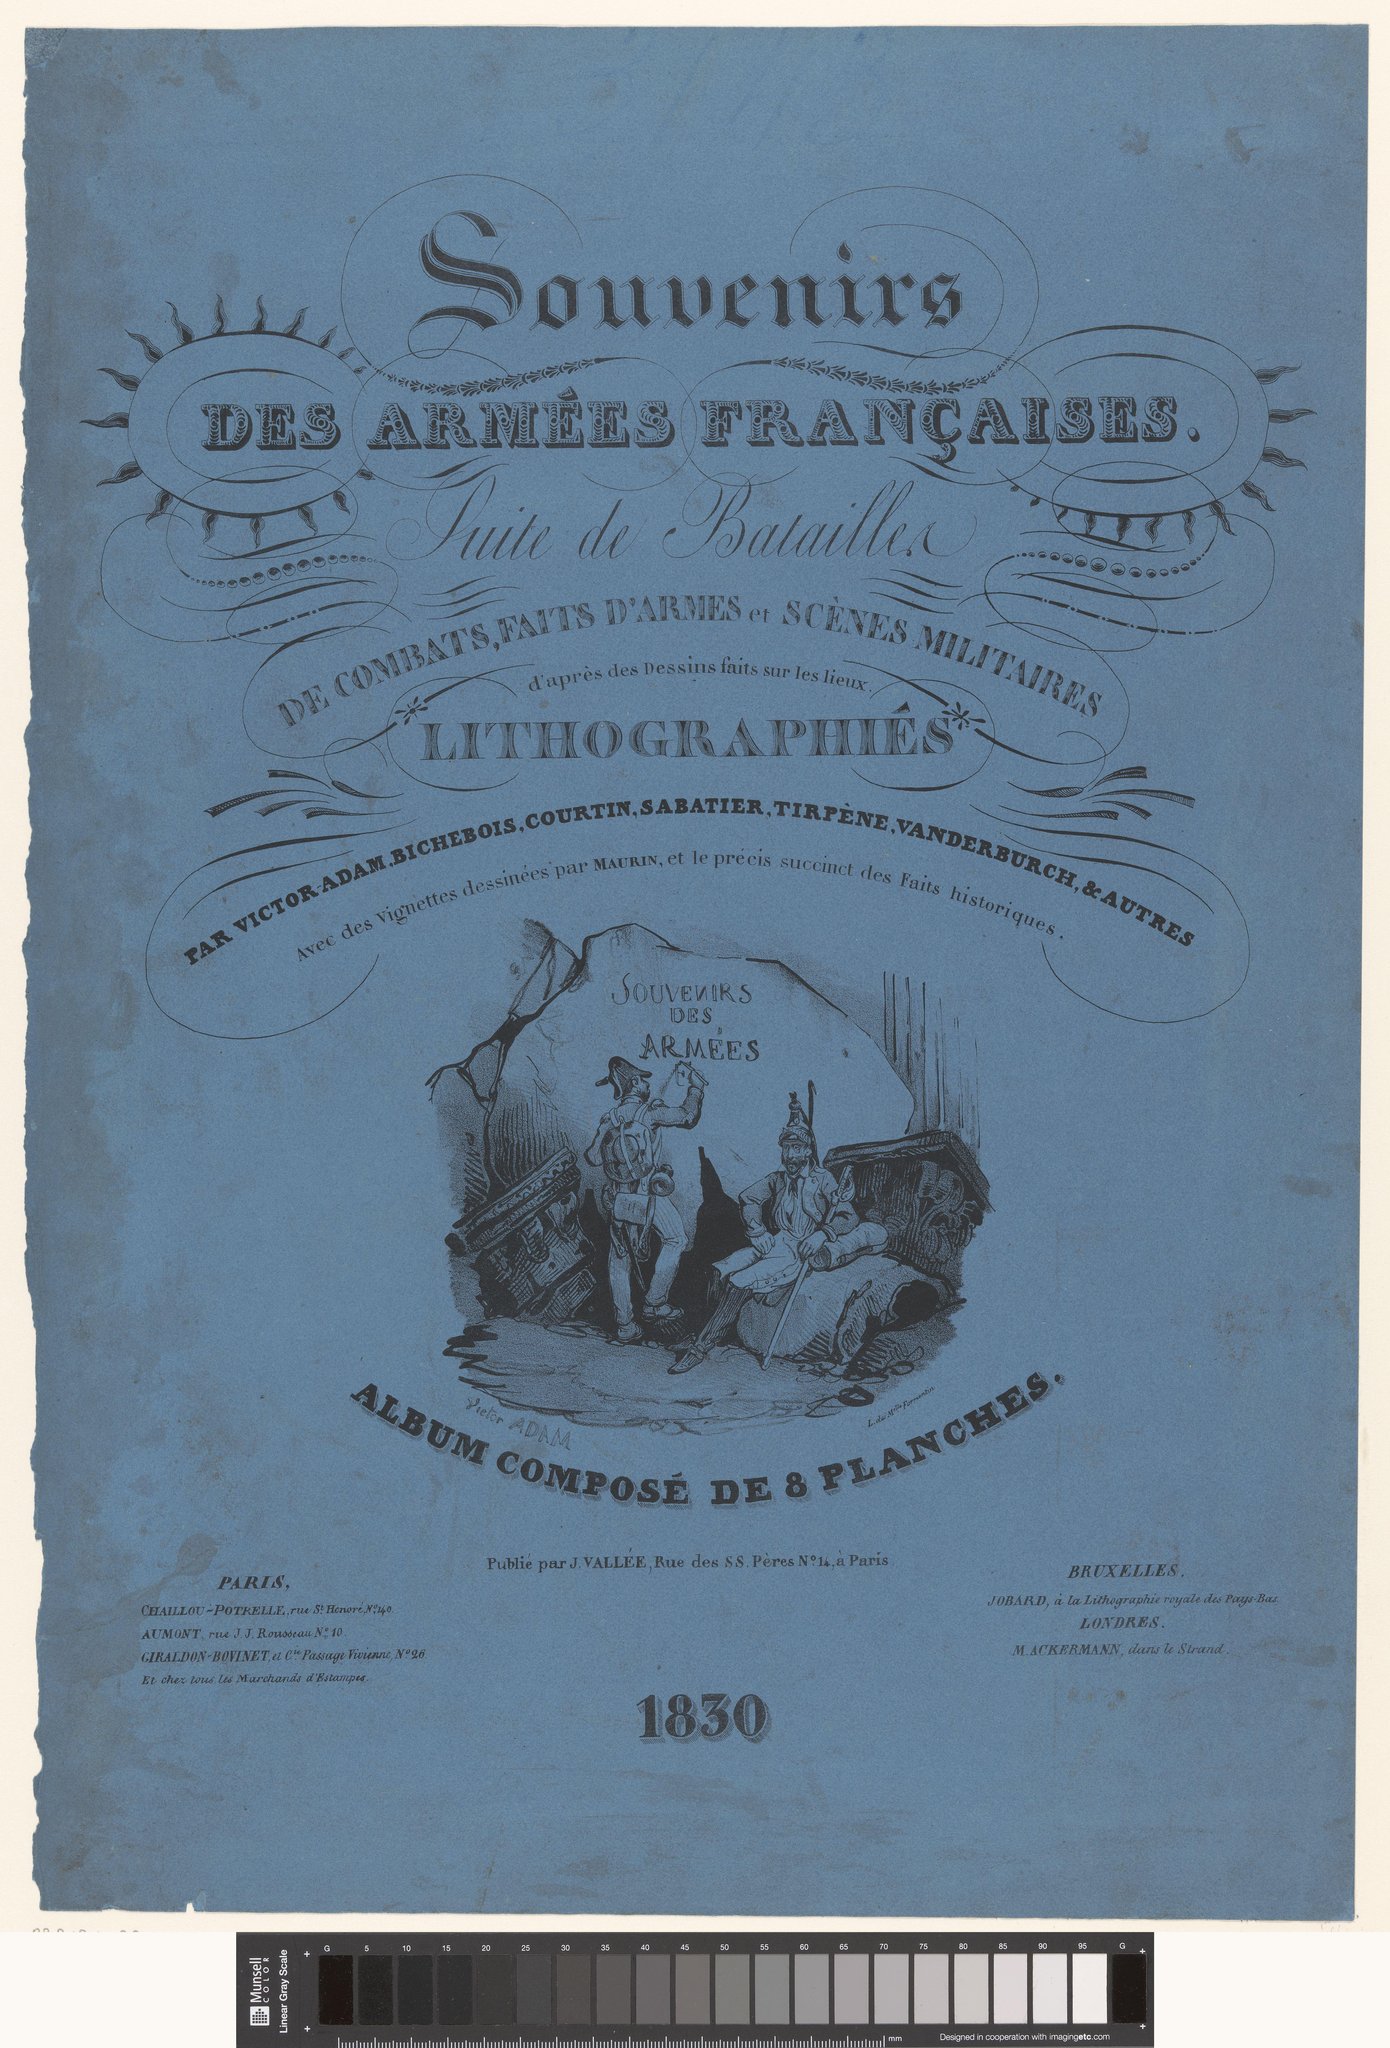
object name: wrapper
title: Omslag voor acht prenten met herinneringen aan het Franse leger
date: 1830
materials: paper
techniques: lithography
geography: paris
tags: land forces, warfare; military affairs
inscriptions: seal: ‘No 86 bis’, seal: ‘1106’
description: Omslag voor acht prenten, met een voorstelling van twee militairen tussen de brokstukken van een ruïne, van wie de linker de tekst 'Souvenirs des Armées' op een brokstuk schrijft.